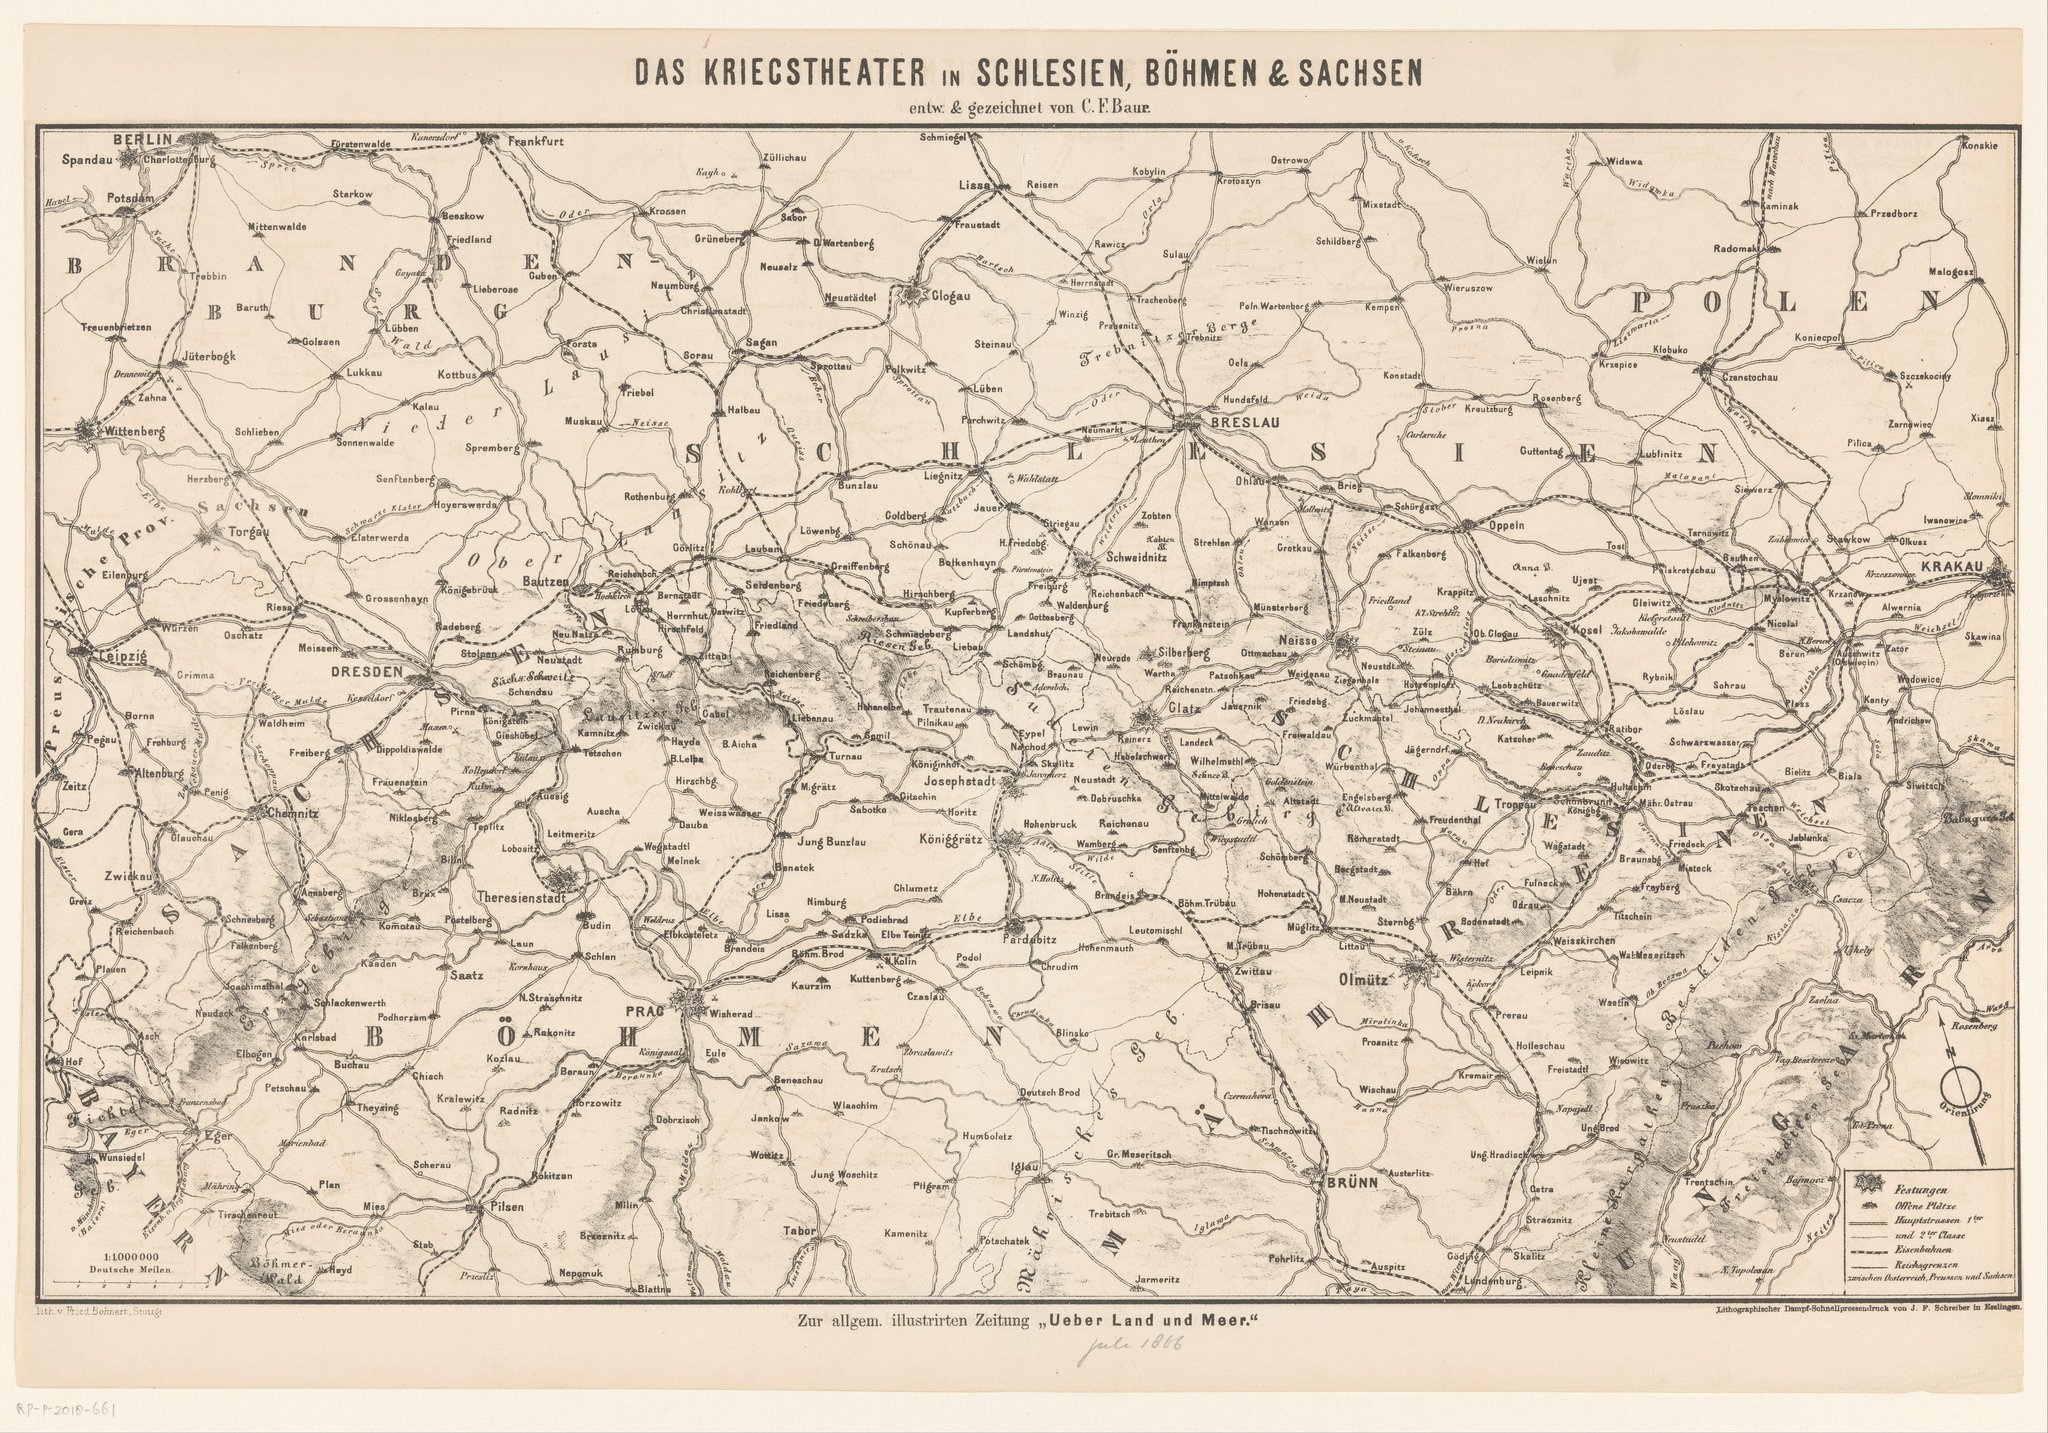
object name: print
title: Das Kriegstheater in Schlesien, Böhemen & Sachsen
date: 1807-1866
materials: paper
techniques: lithograph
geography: germany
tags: maps of separate countries or regions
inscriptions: collector's mark: Lugt 2228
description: Kaart van het strijdtoneel in Silezië, Bohemen en Saksen, tijdens de Oostenrijks-Pruisische Oorlog van 1866.